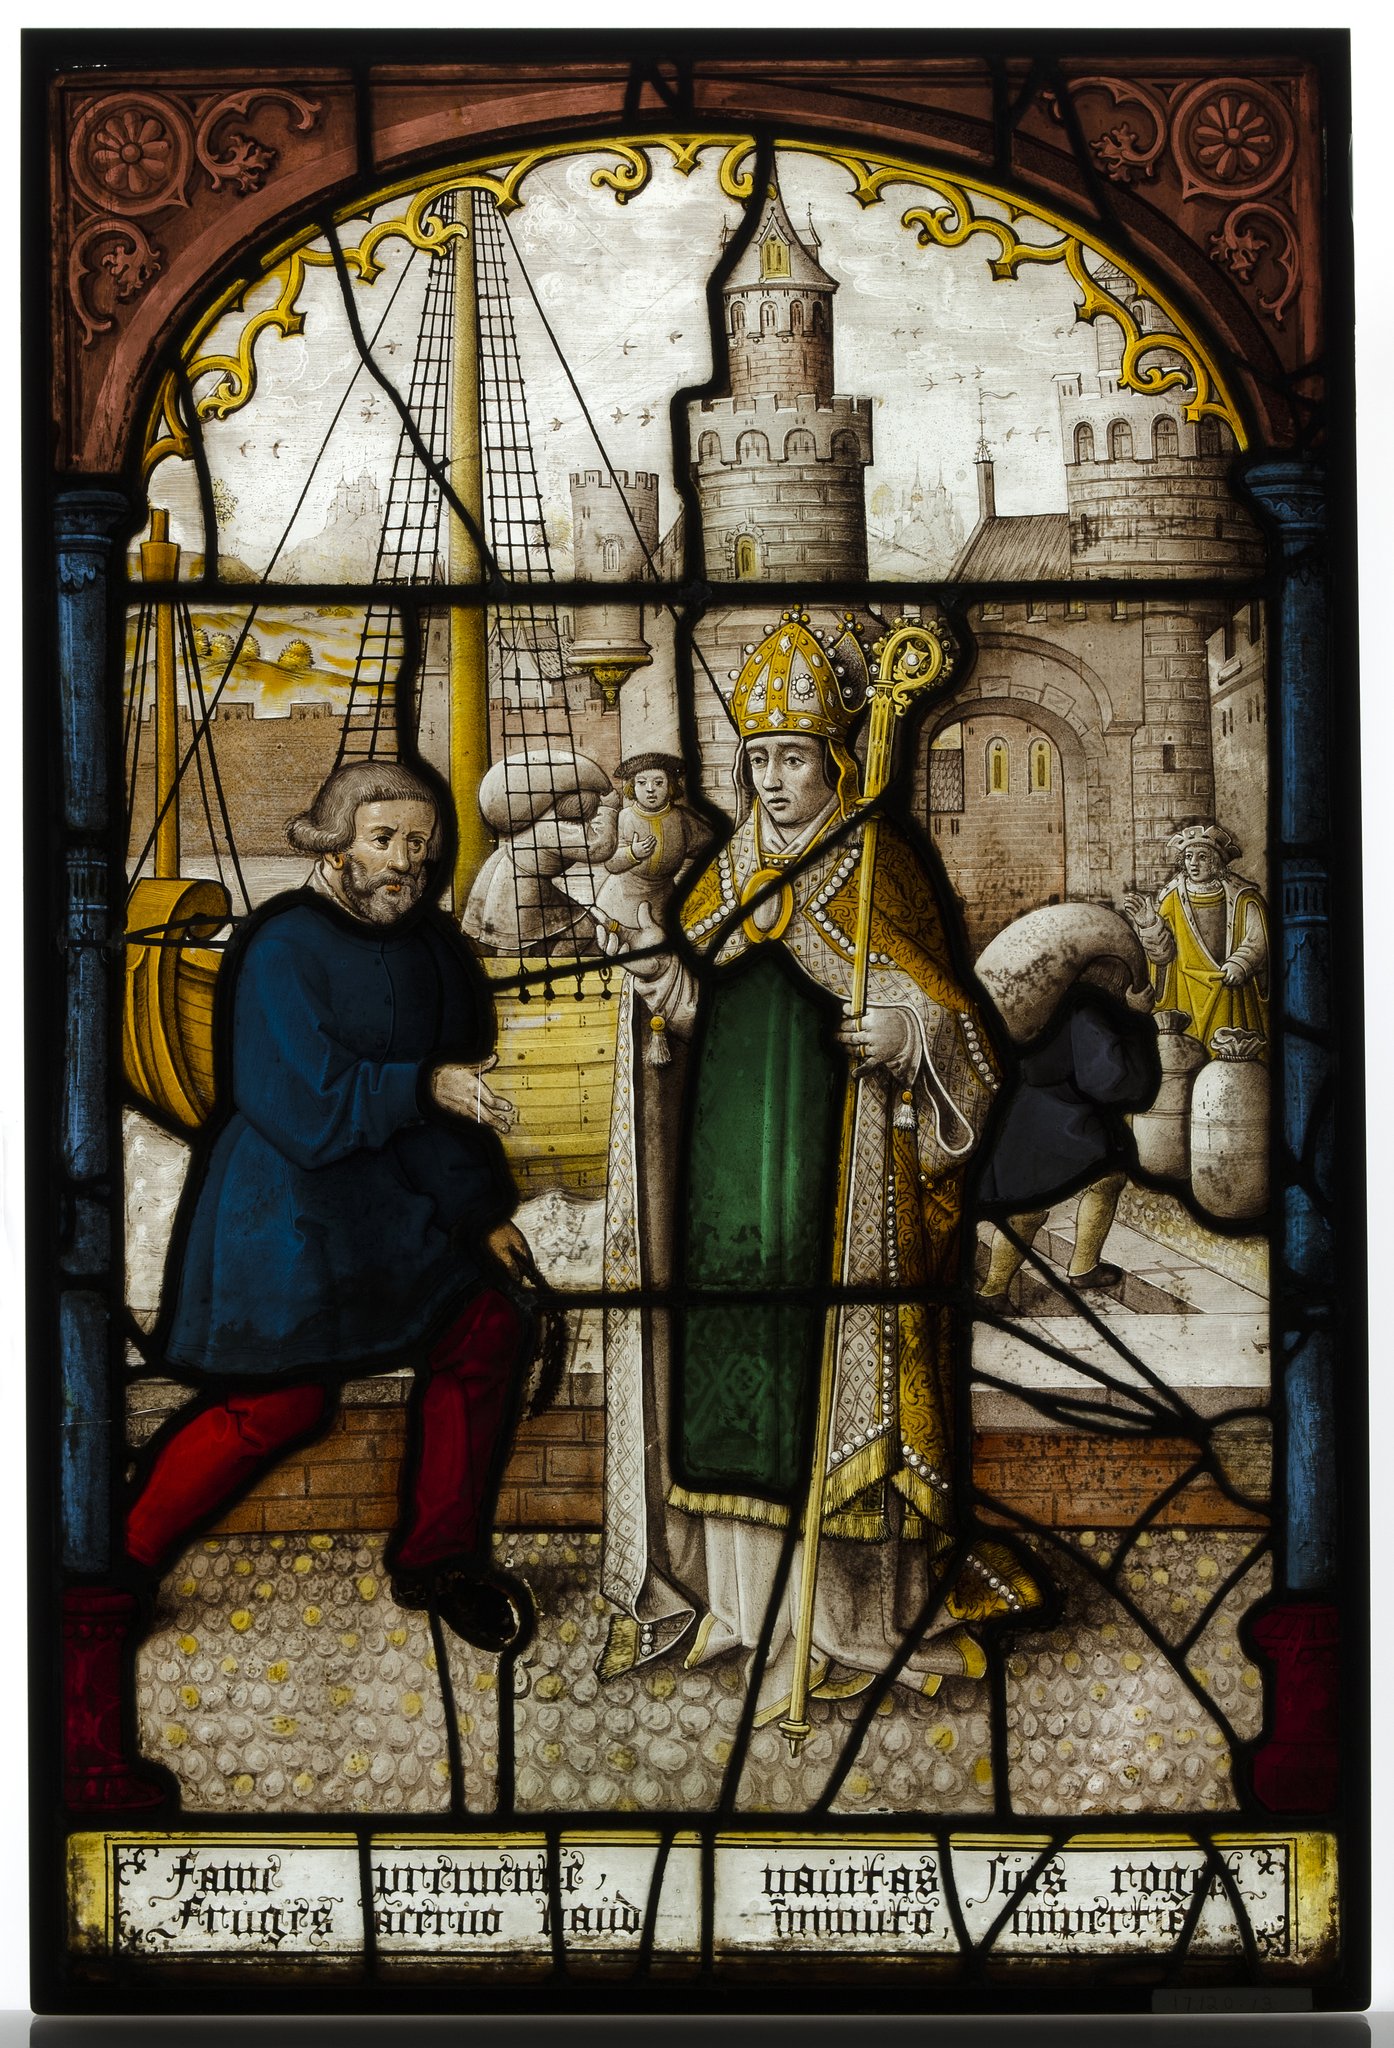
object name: panel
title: Glass Panel of Saint Nicholas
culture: dutch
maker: jacob cornelisz van oostsanen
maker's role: artist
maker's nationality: netherlandish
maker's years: 1465-1533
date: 1501-1600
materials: glass, metal, paint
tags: men,ships